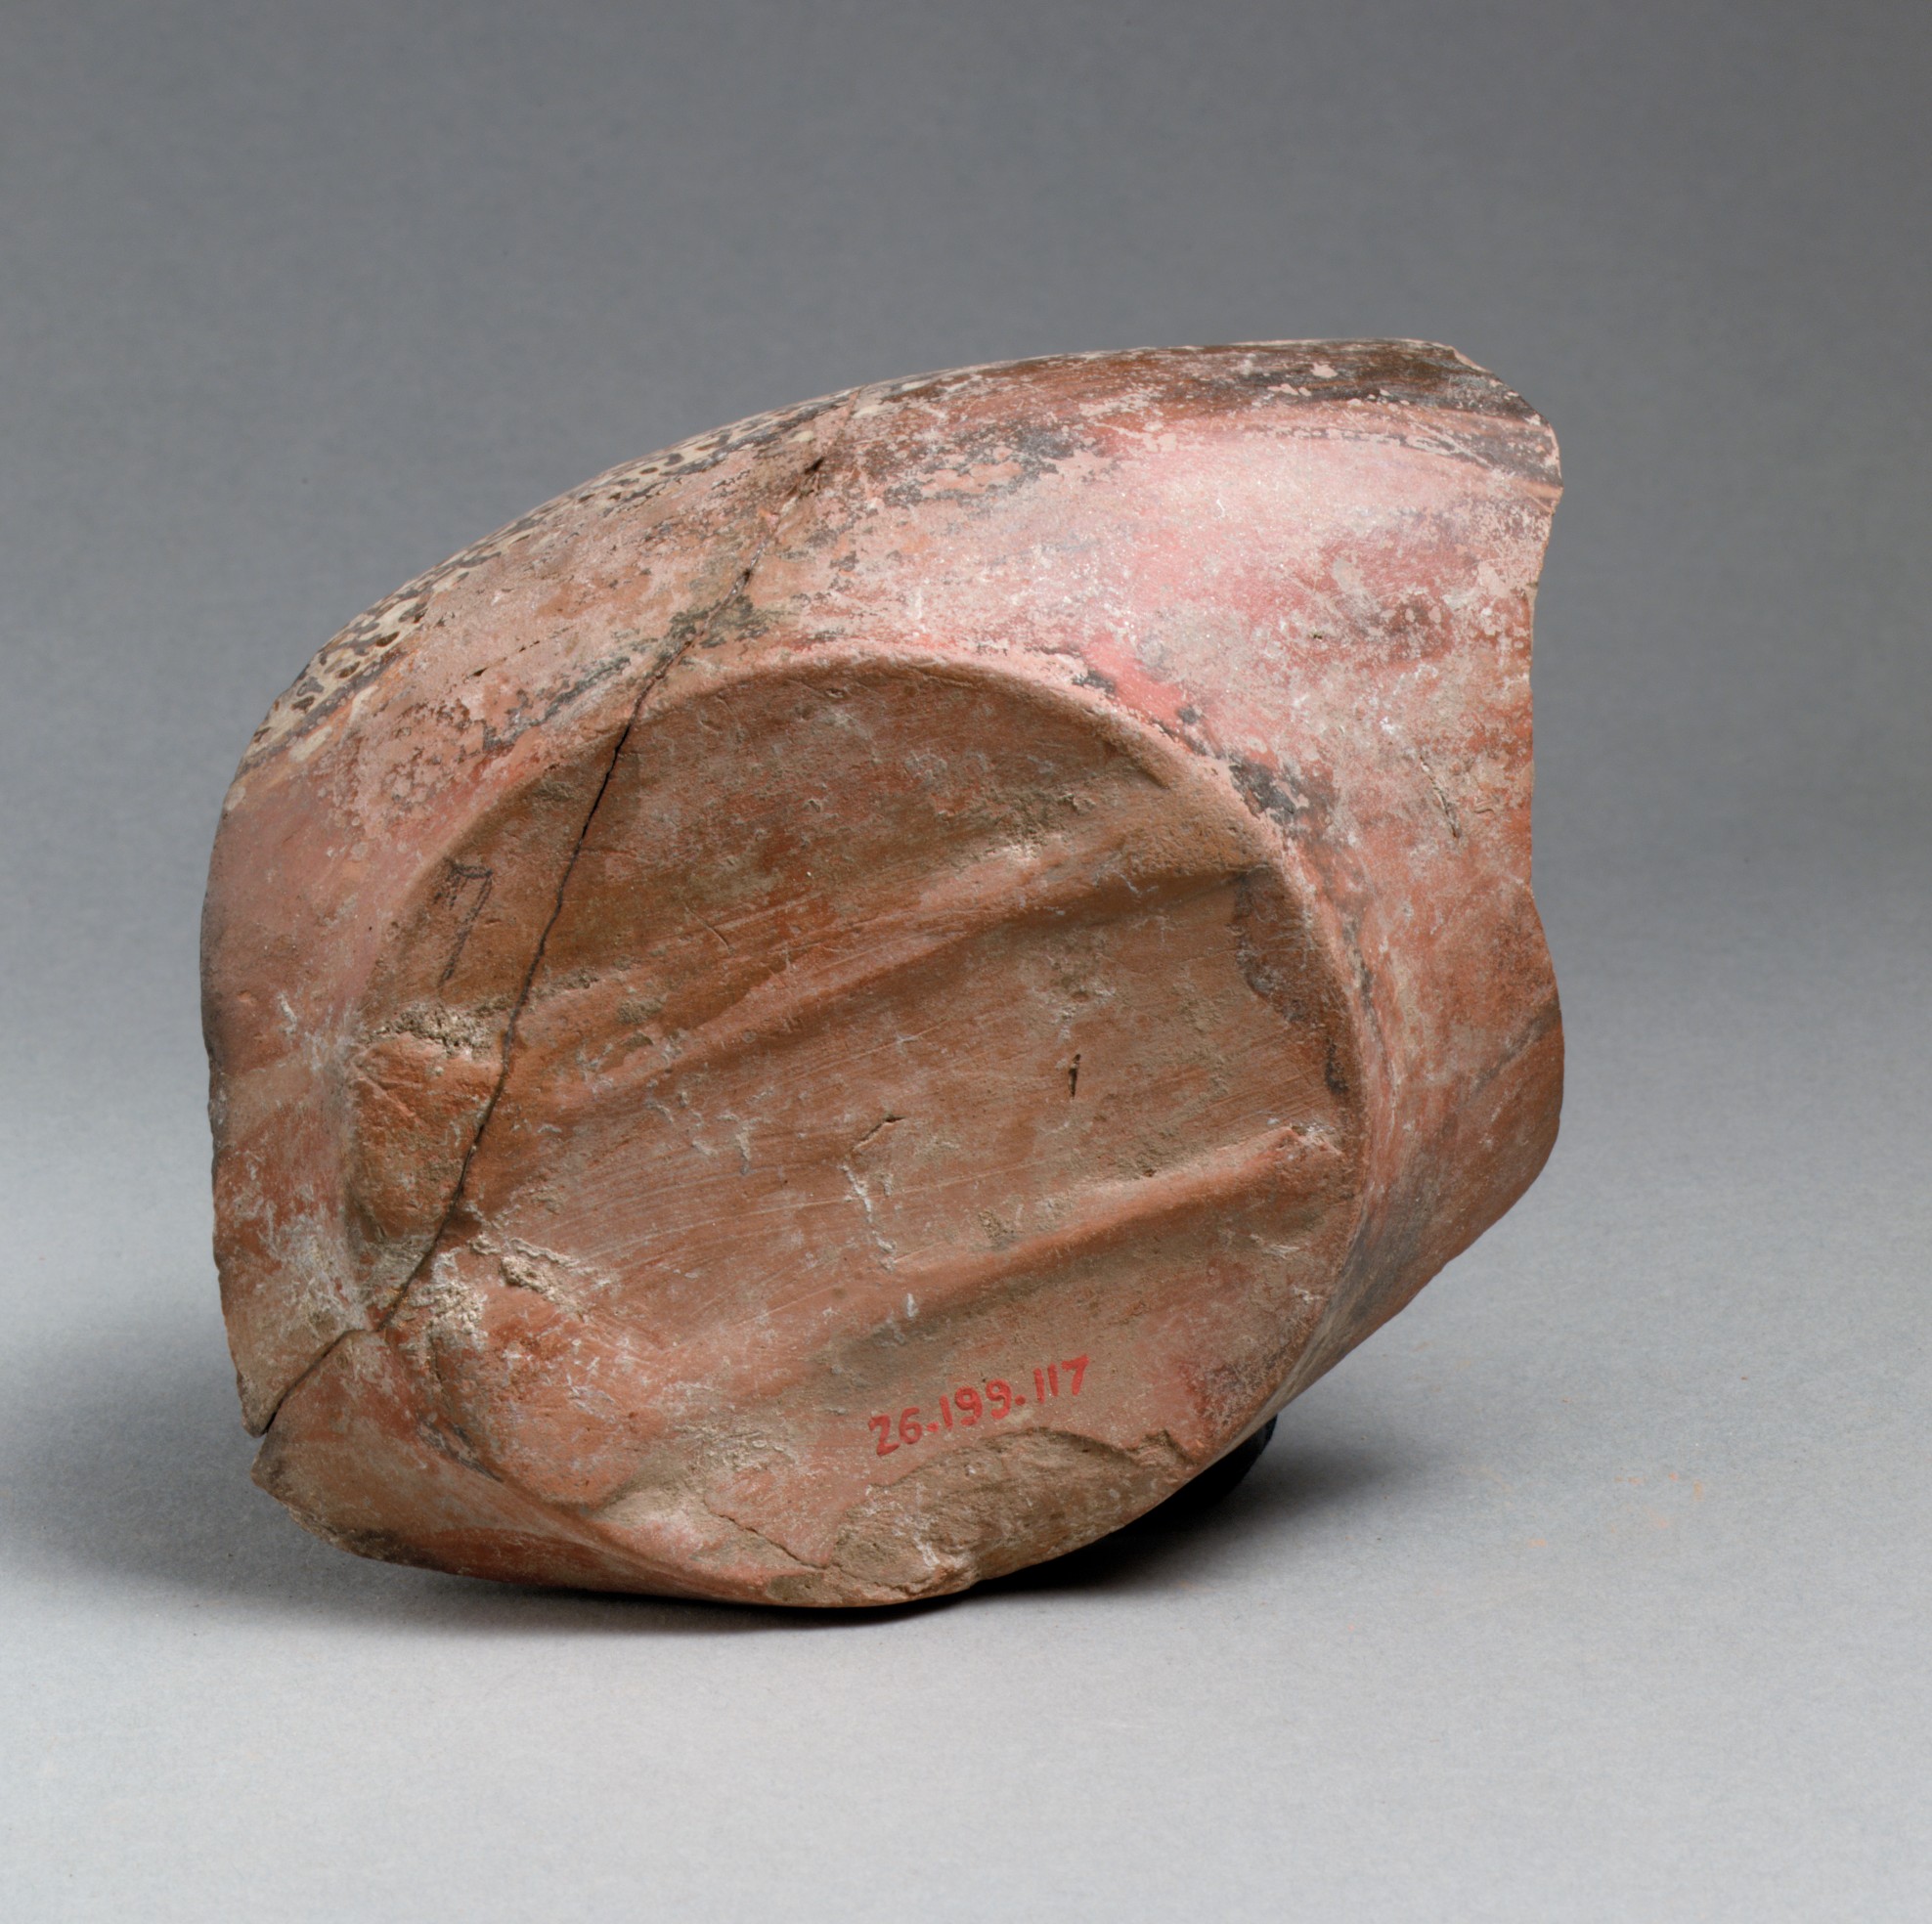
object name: vase fragment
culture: greek or lydian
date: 900-30 BCE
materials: terracotta